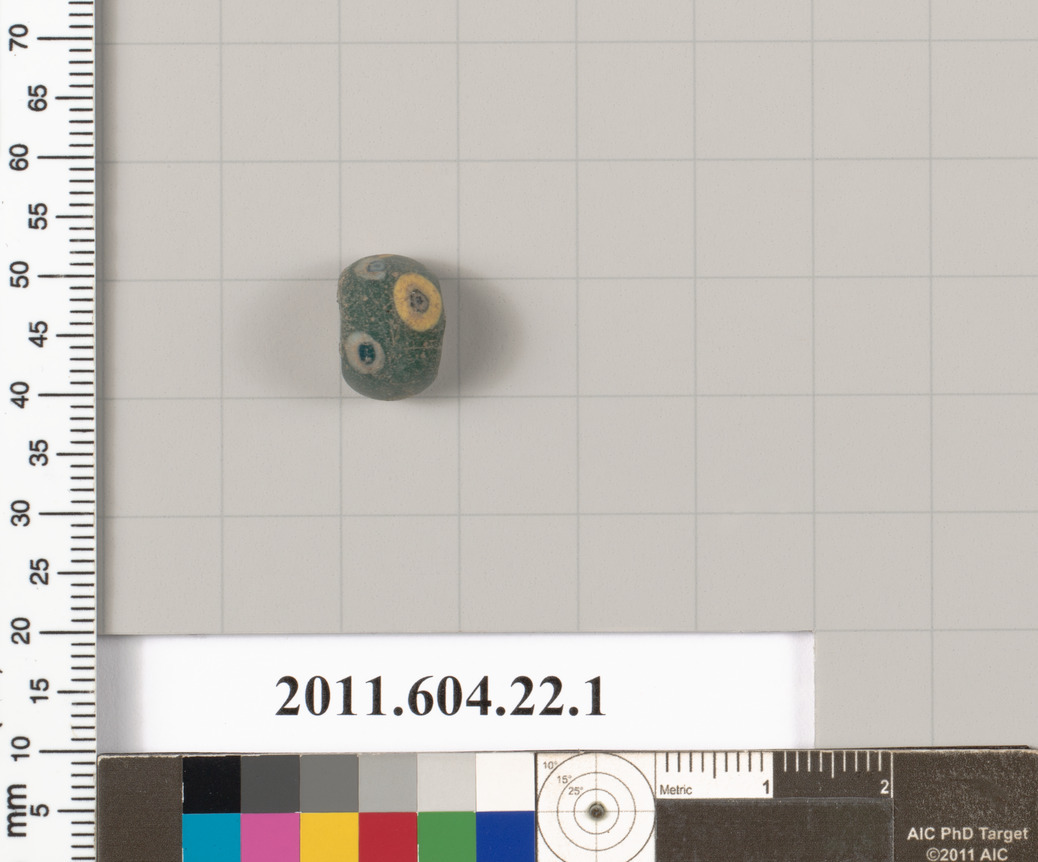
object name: bead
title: Glass eye bead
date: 600-201 BCE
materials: glass